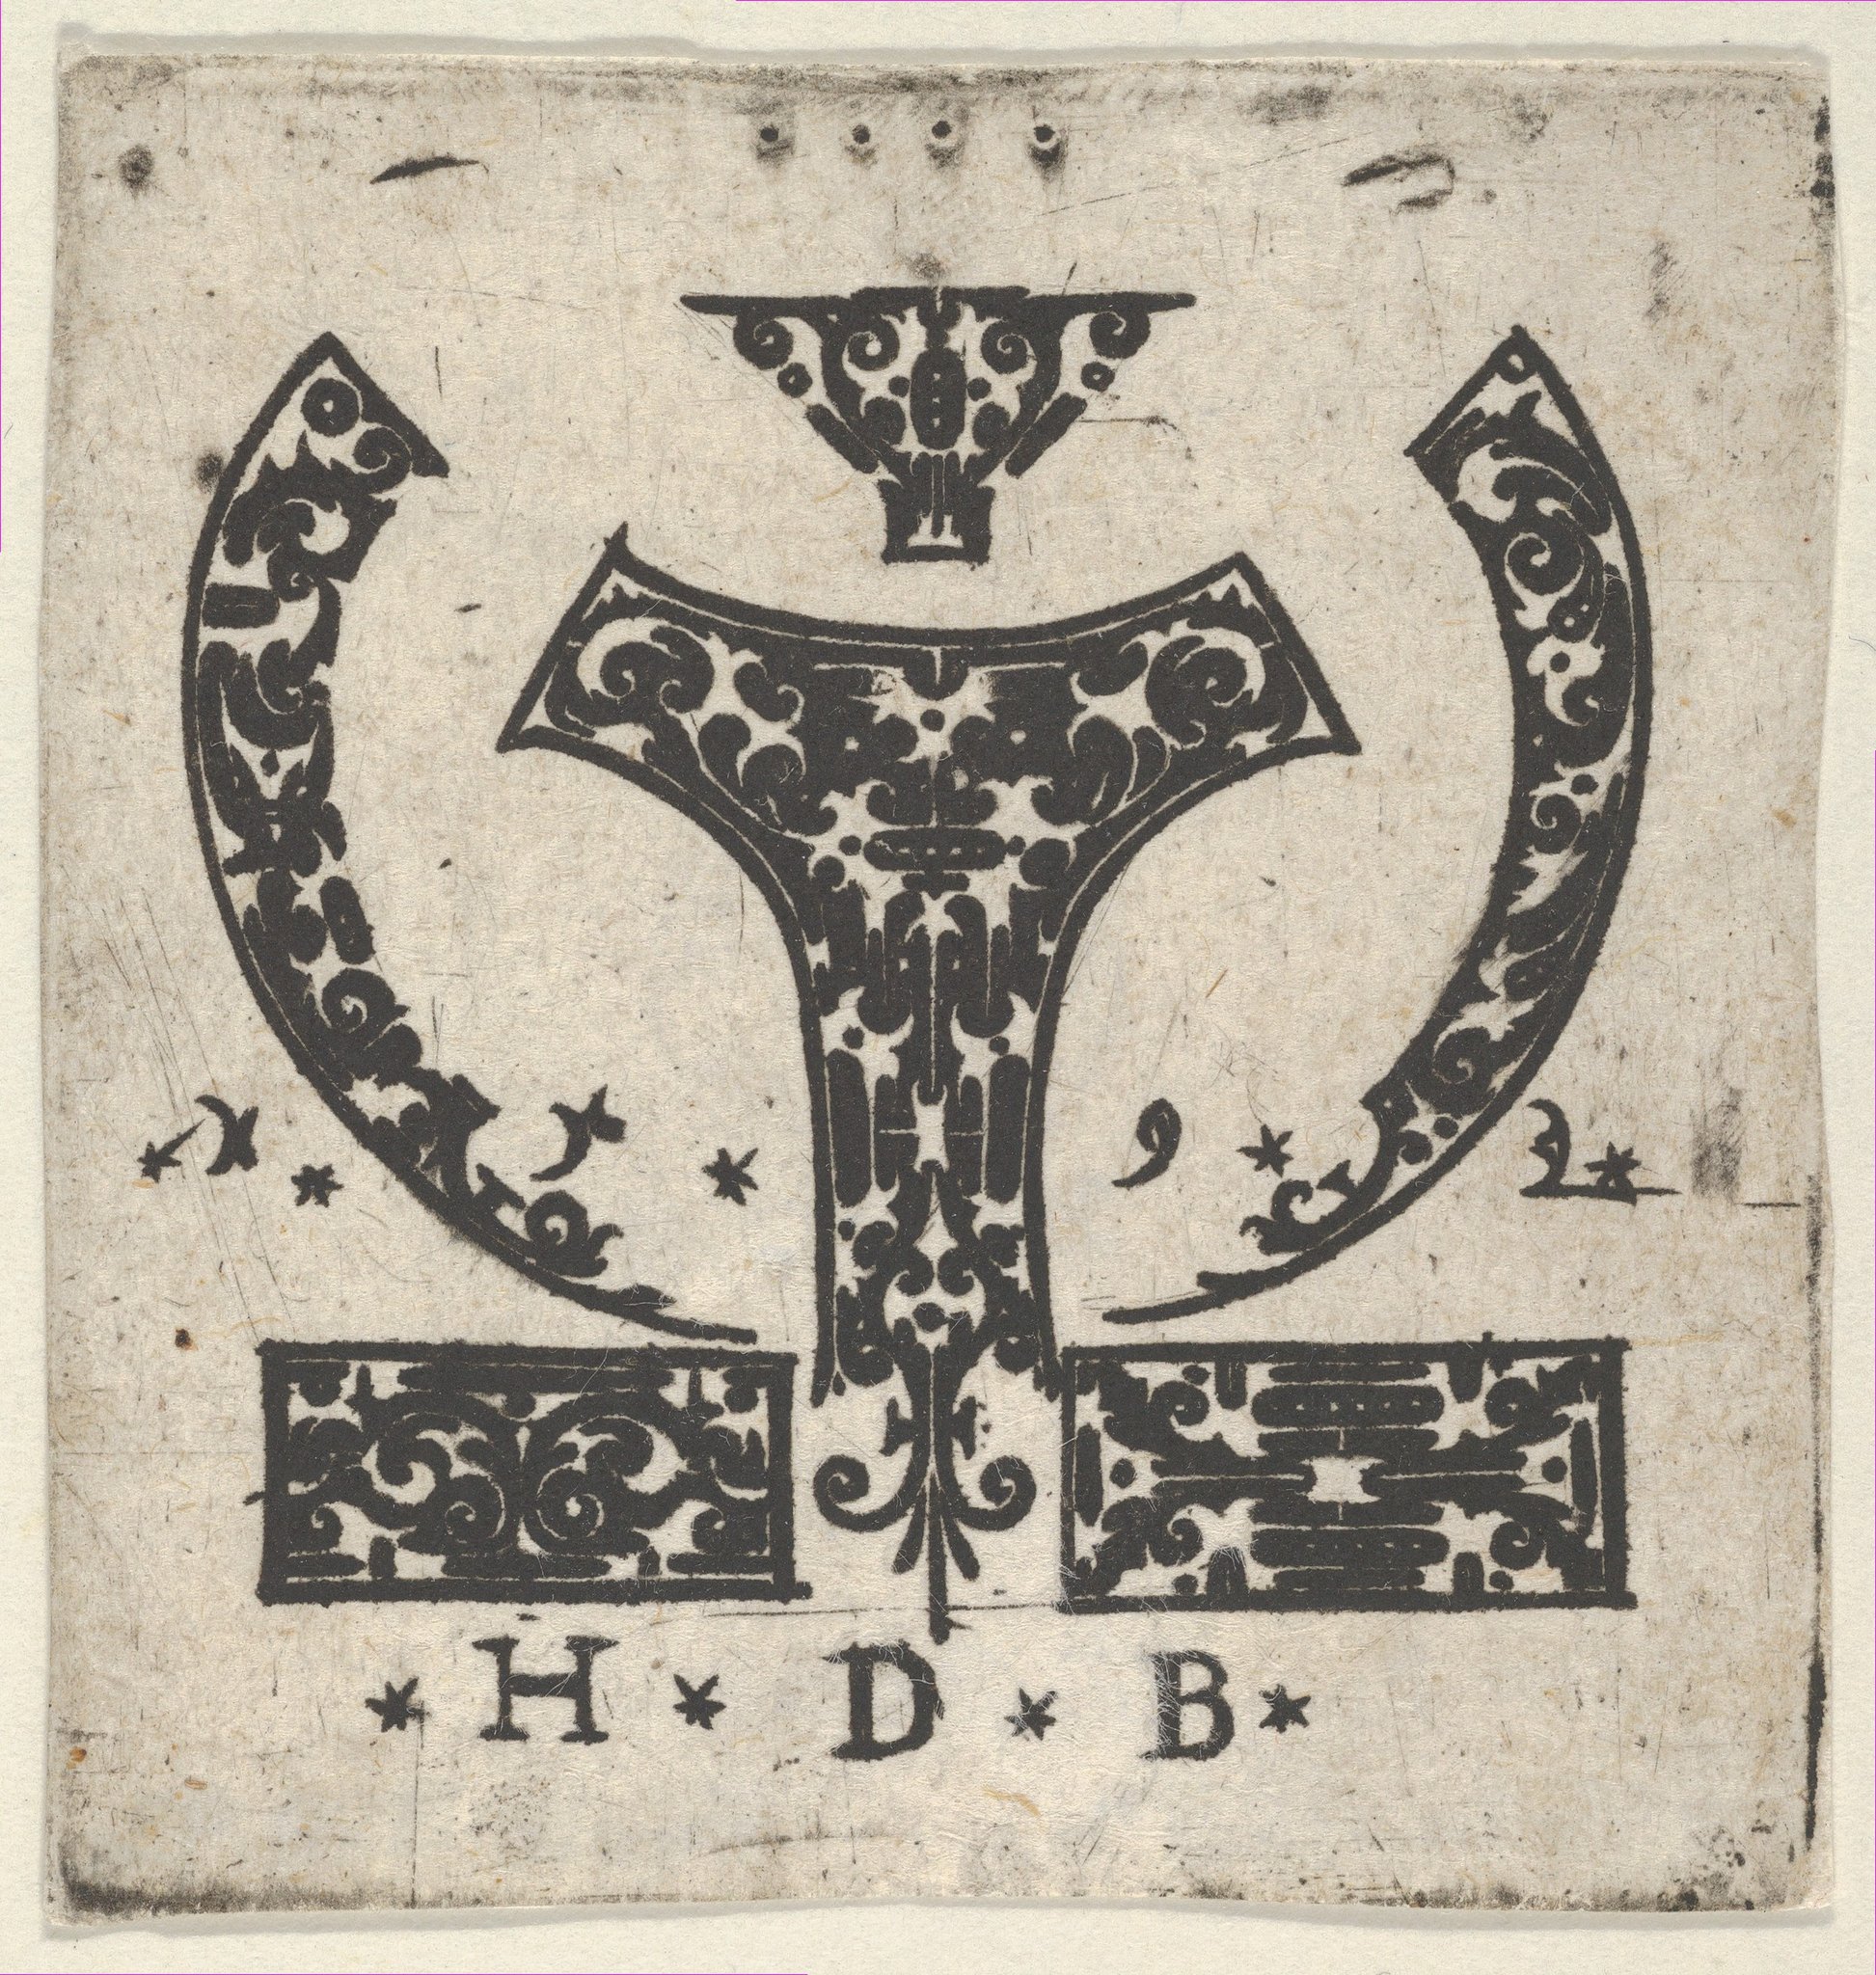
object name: print ornament architecture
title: Blackwork Print with Two Horizontal Panels Below a Pair of Lunar-Shaped Fillets with Two Motifs at Center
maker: hans de bull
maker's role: artist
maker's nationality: german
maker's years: 1592-1604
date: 1592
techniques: embroidery, engraving